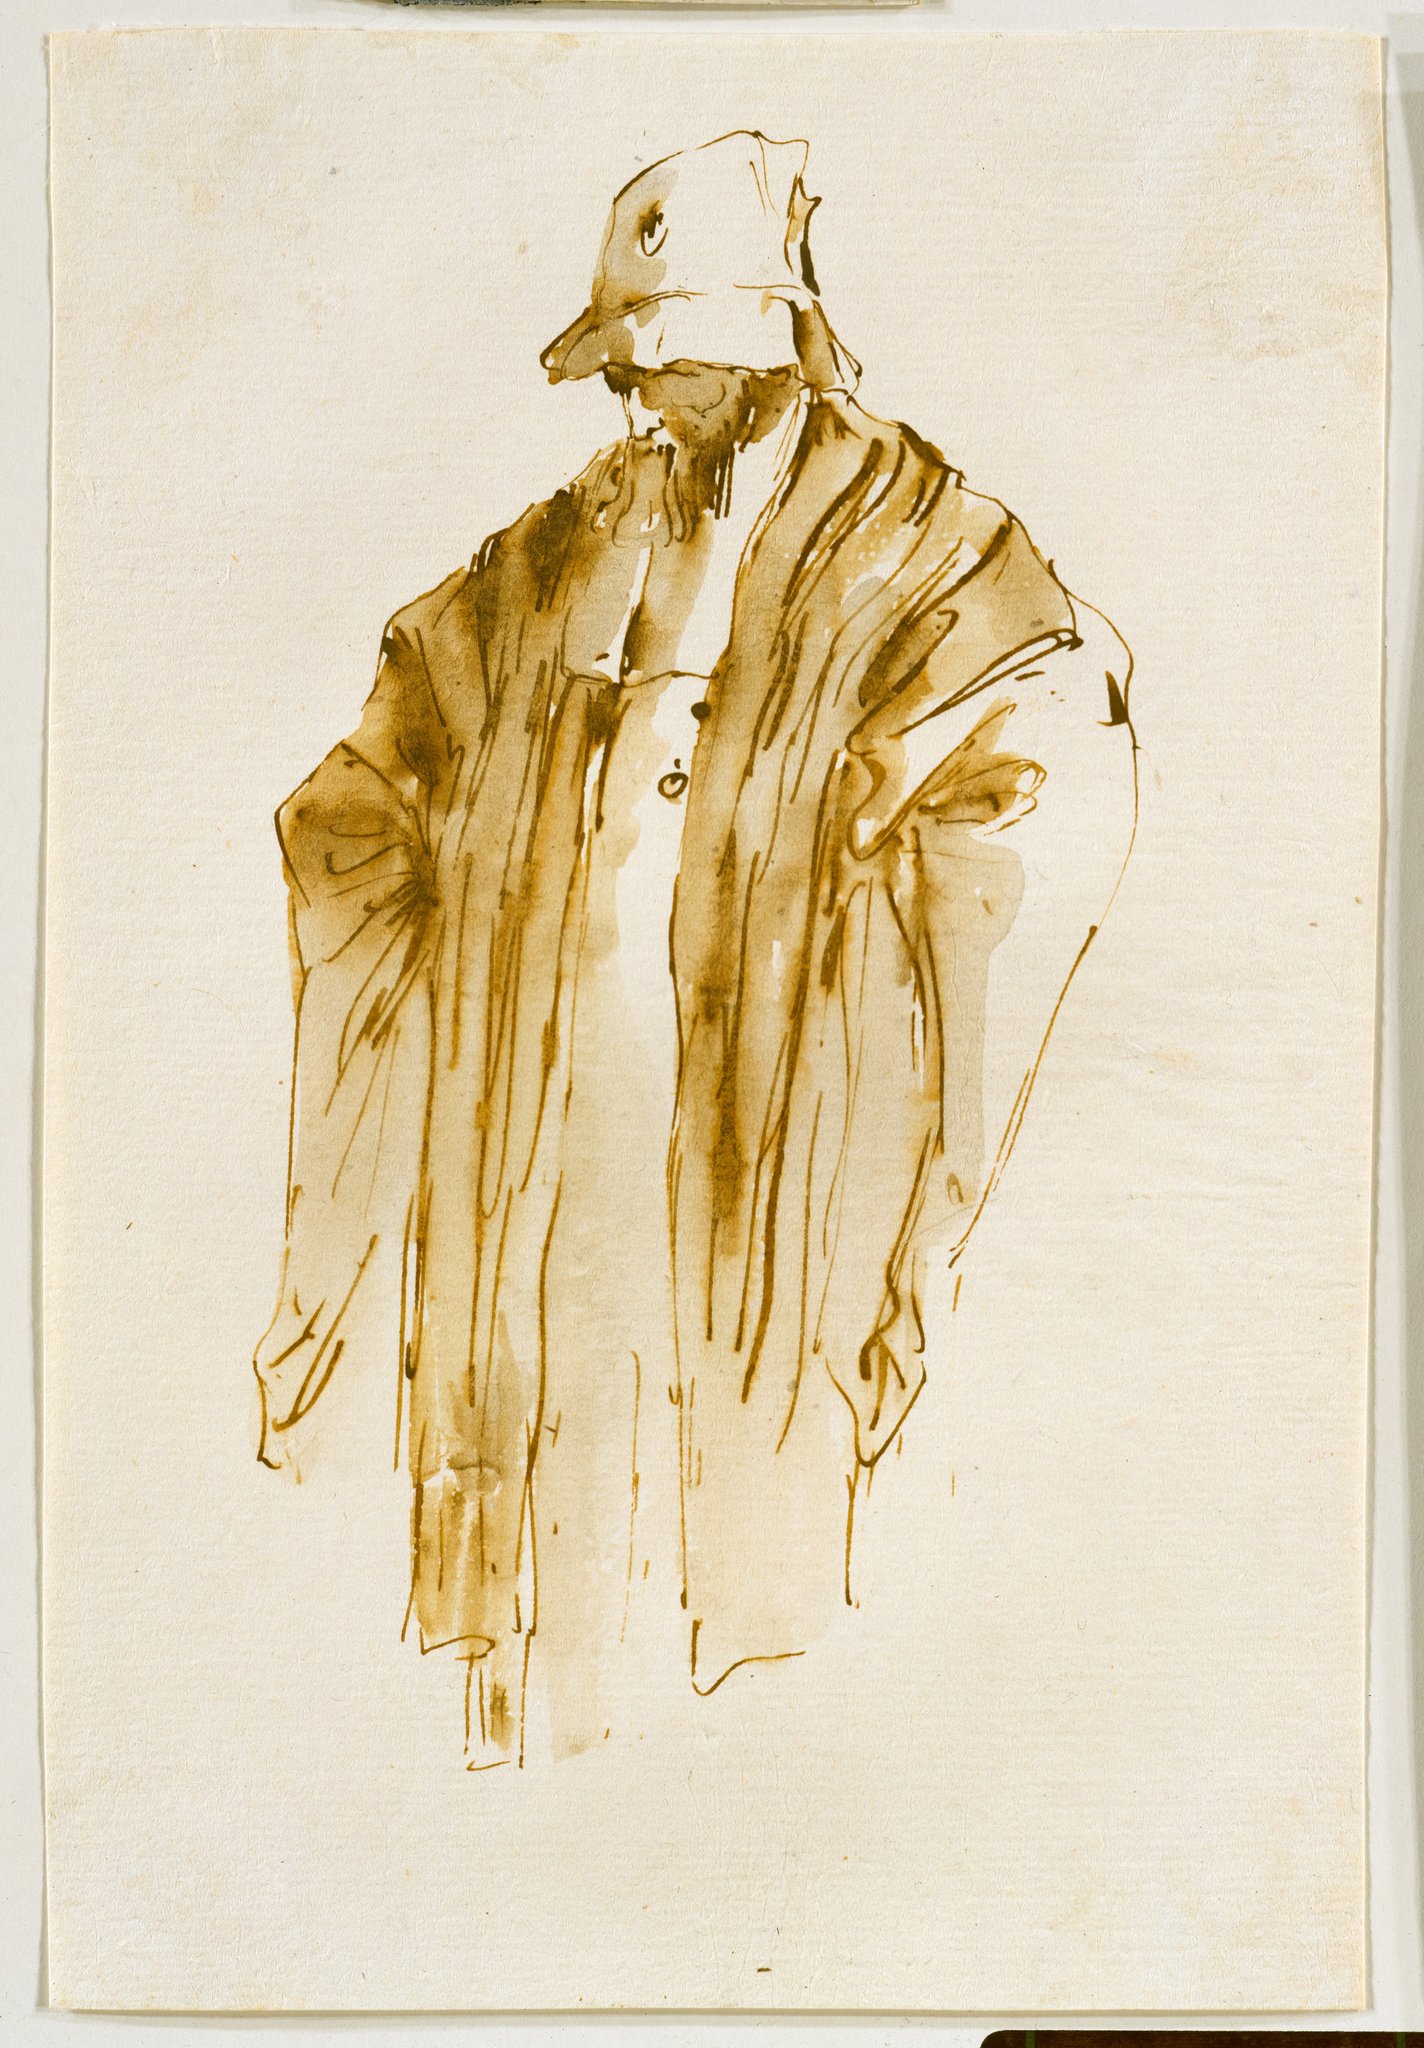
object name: drawing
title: Bearded Man Looking Down to the Left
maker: giovanni battista tiepolo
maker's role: artist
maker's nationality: italian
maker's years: 1696-1770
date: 1760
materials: ink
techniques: pen, wash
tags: men